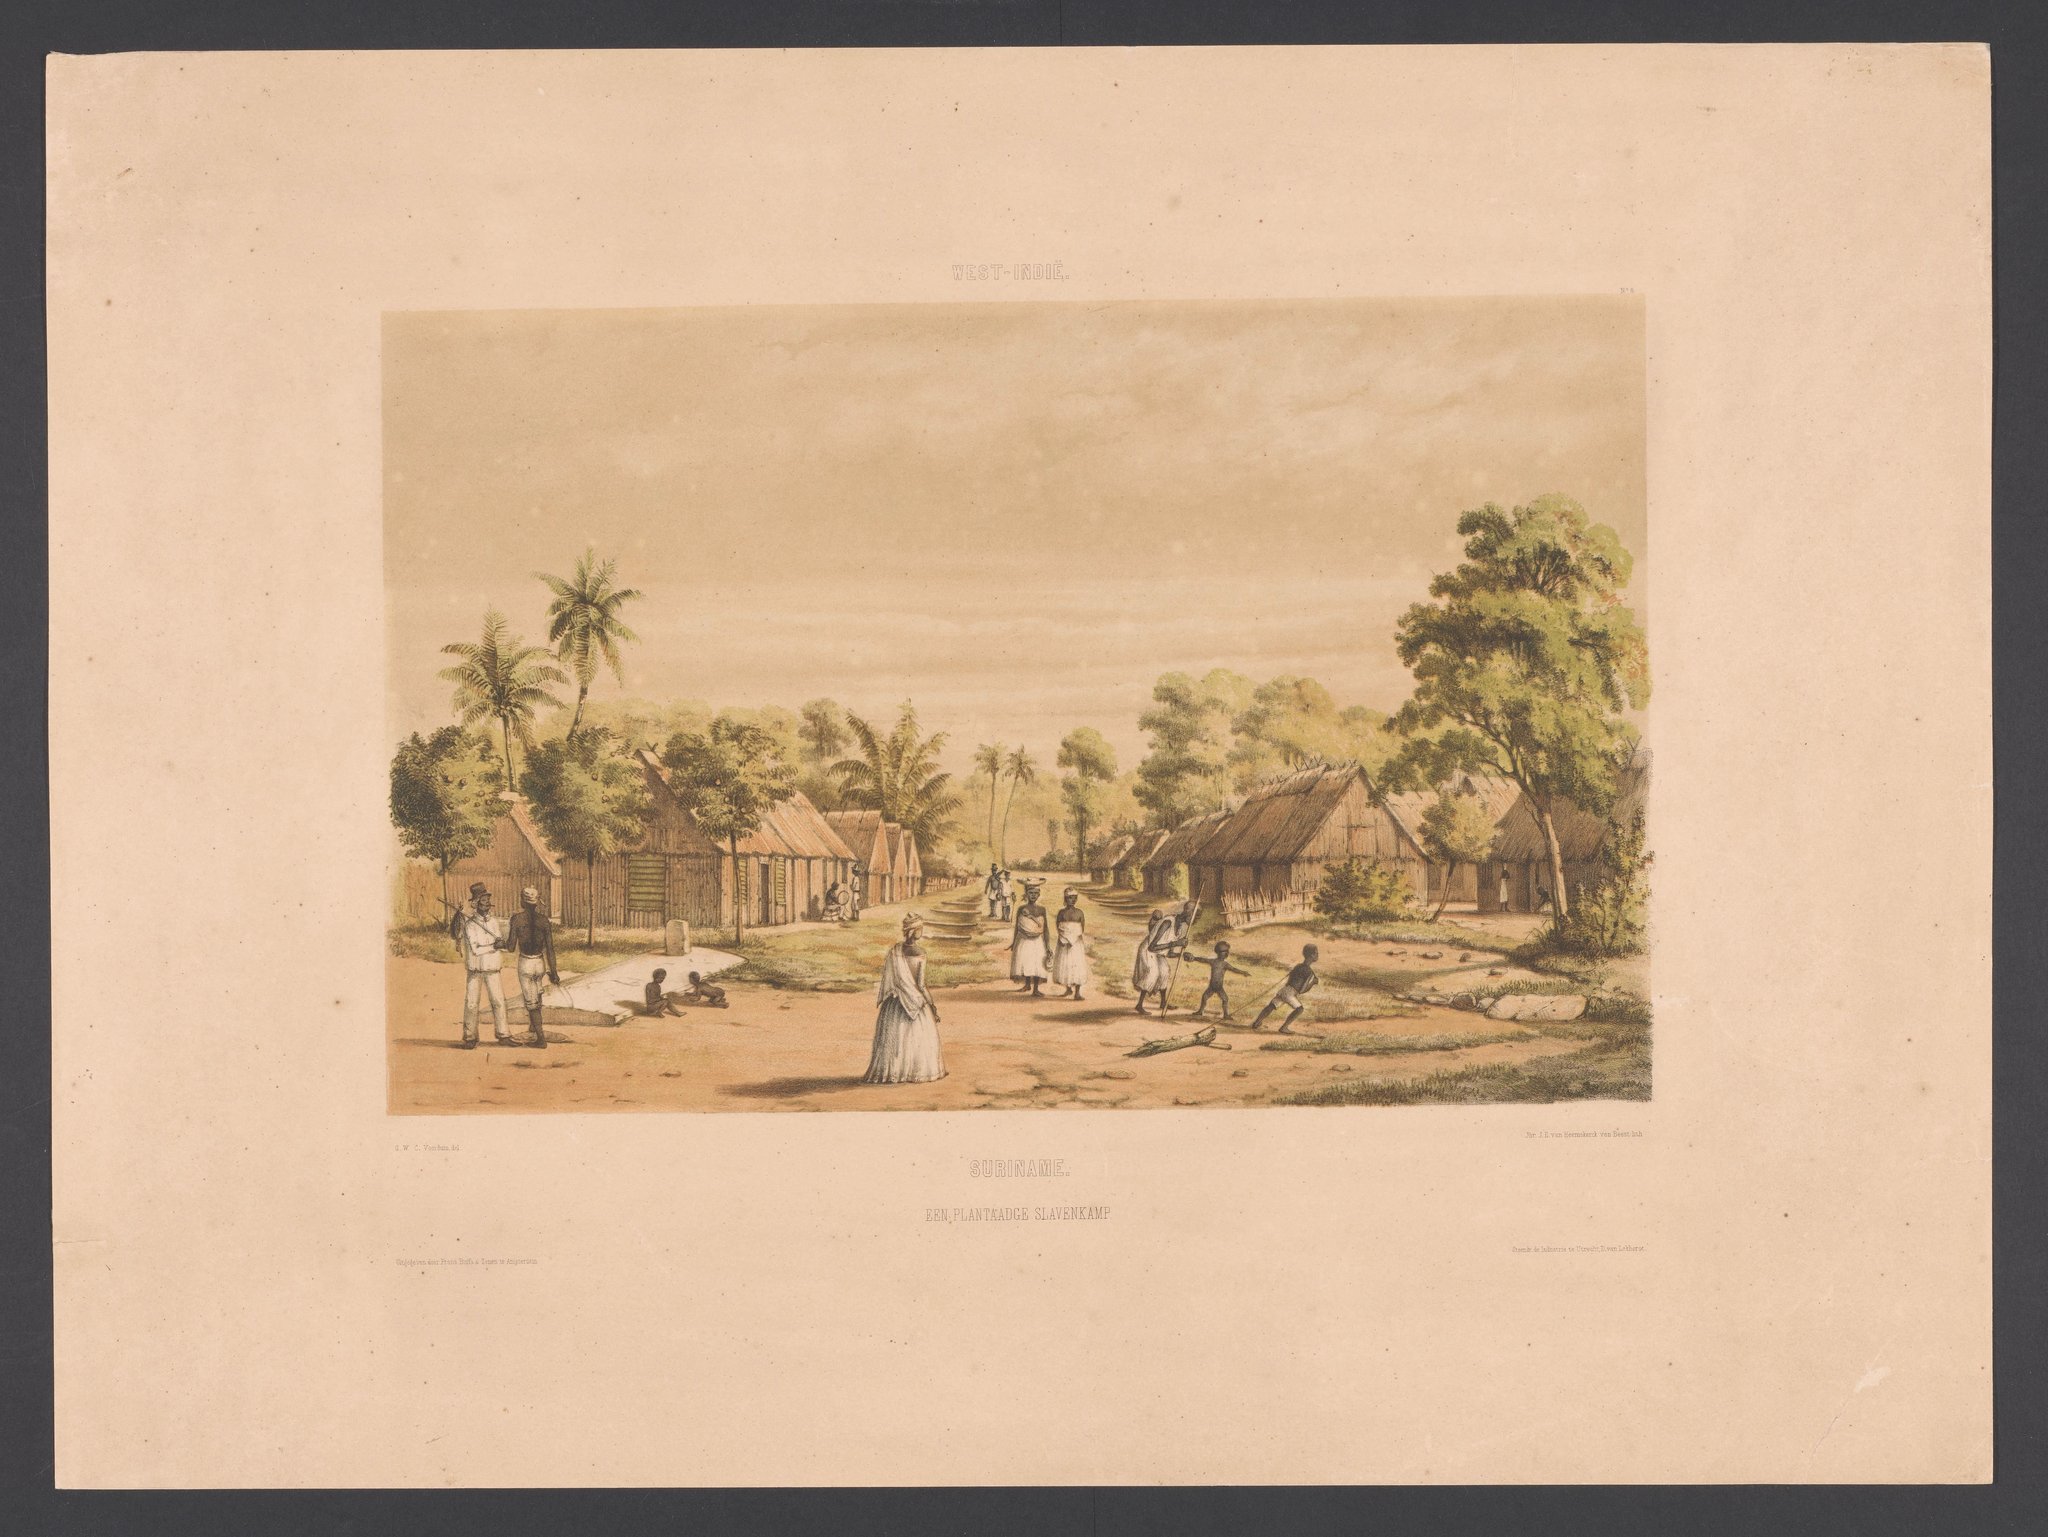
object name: print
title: West-Indië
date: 1860-1862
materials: paper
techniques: lithograph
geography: amsterdam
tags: plantation, slavery; serfs and enslaved persons, carrying something on the head or on the shoulders, suriname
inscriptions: collector's mark: Lugt 2228, collector's mark: Lugt 2760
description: Gezicht op woningen van tot slaaf gemaakten op een Surinaamse plantage. Voor en tussen de woningen verschillende tot slaaf gemaakte vrouwen, mannen en kinderen. Prent maakt deel uit van een omslag met zeventien bladen.